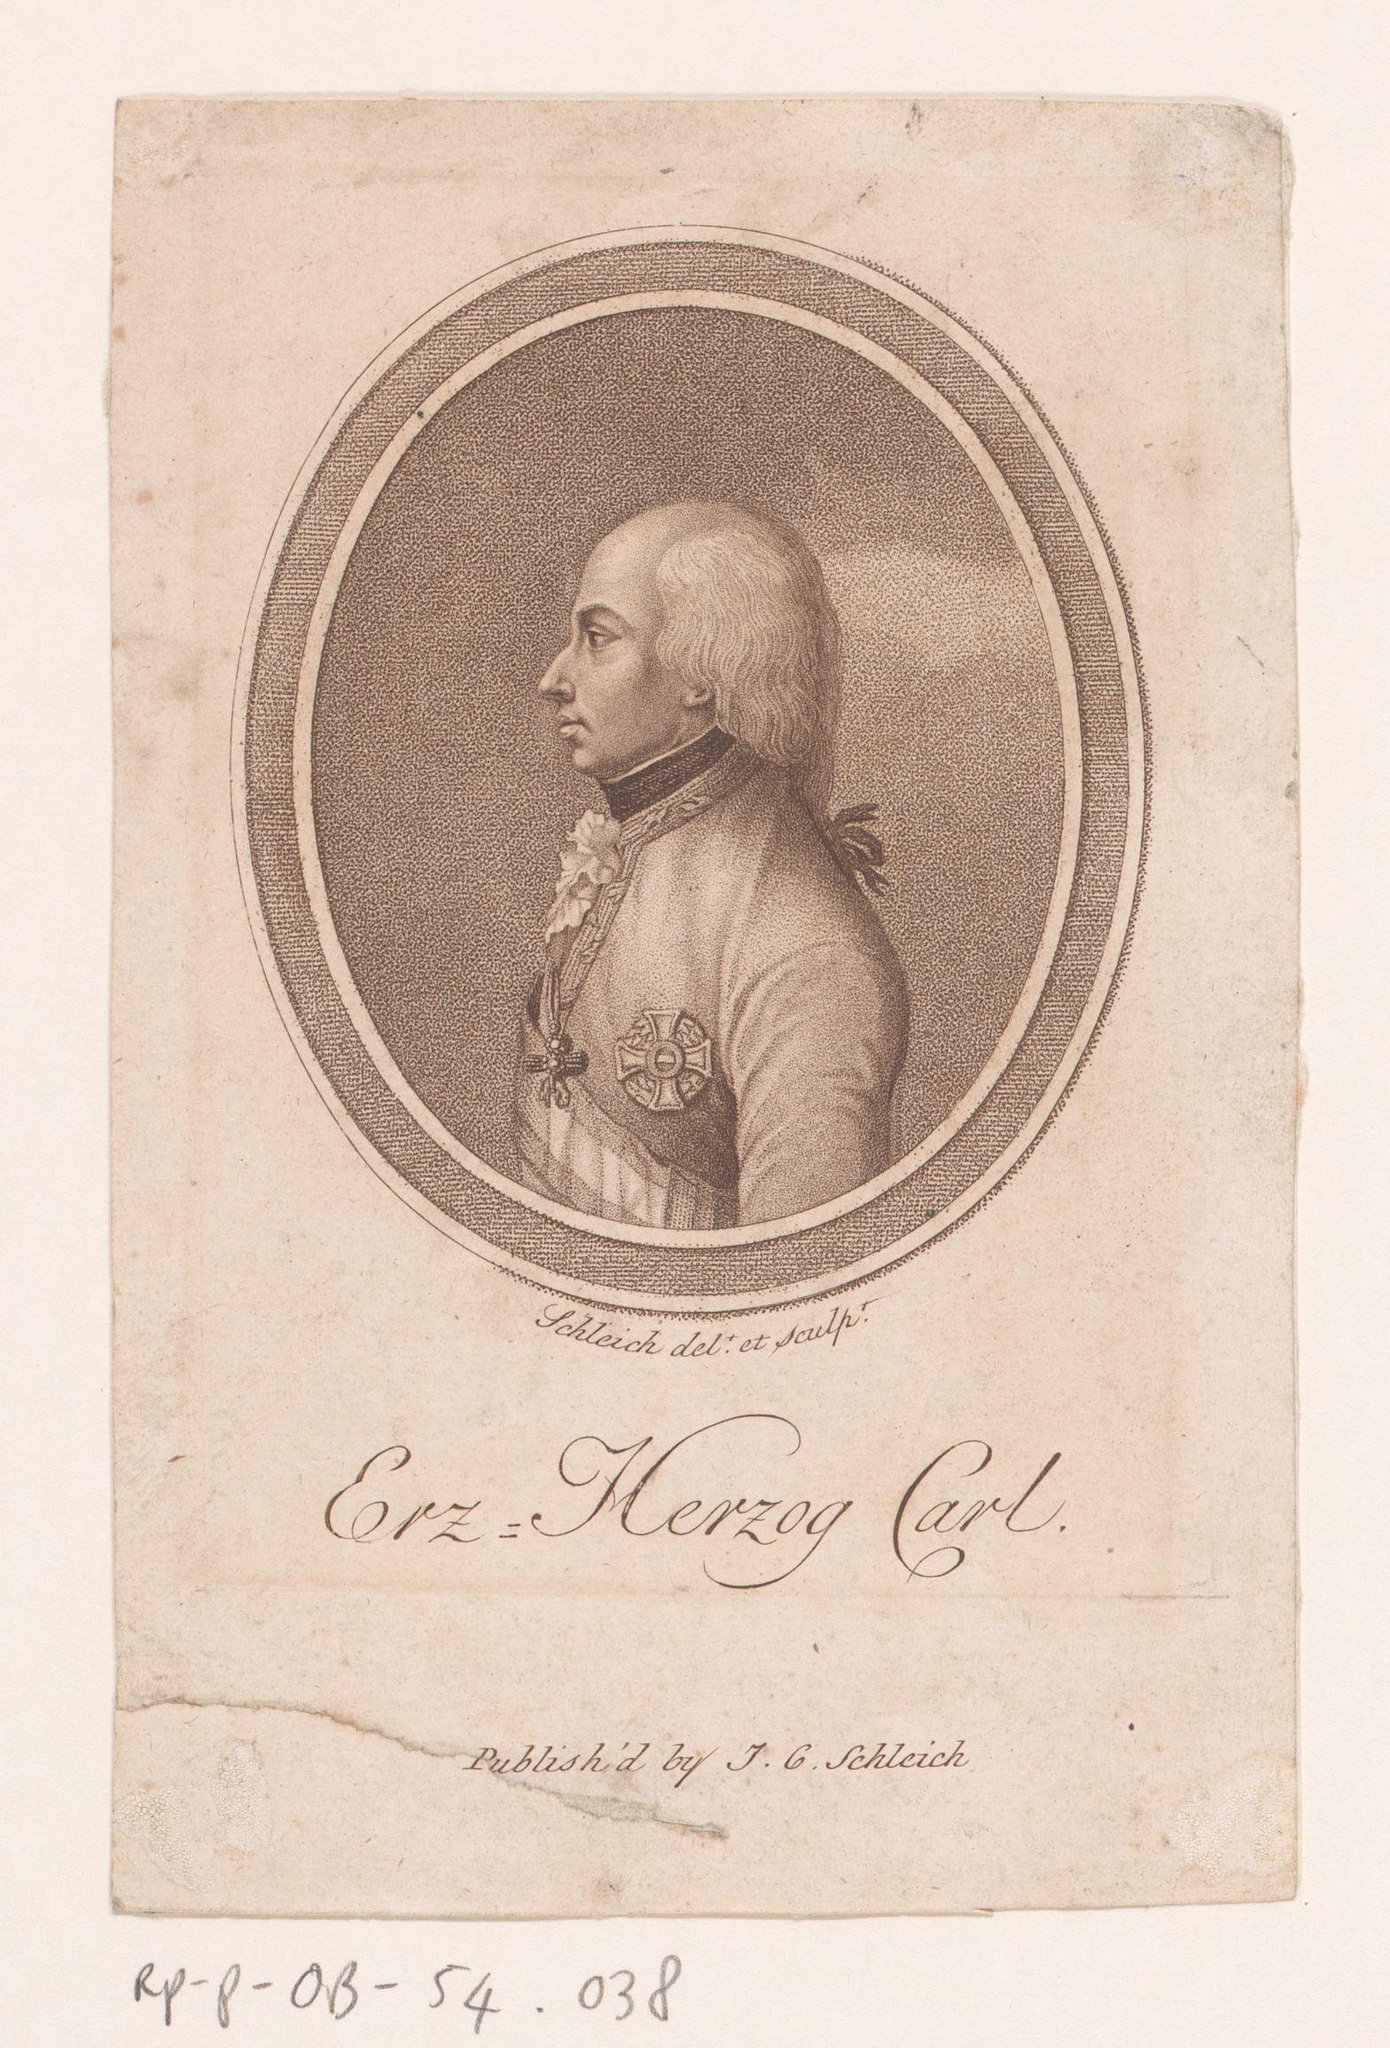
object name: print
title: Portret van Karel Lodewijk Johan, landvoogd der zuidelijke Nederlanden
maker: johann carl schleich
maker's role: print maker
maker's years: 1759-1842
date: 1769-1842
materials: paper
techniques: printing, engraving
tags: vienna, historical persons, knighthood order of the golden fleece - insignia of a knighthood order, e.g.: badge, chain (with name of order)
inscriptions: collector's mark: Lugt 2228